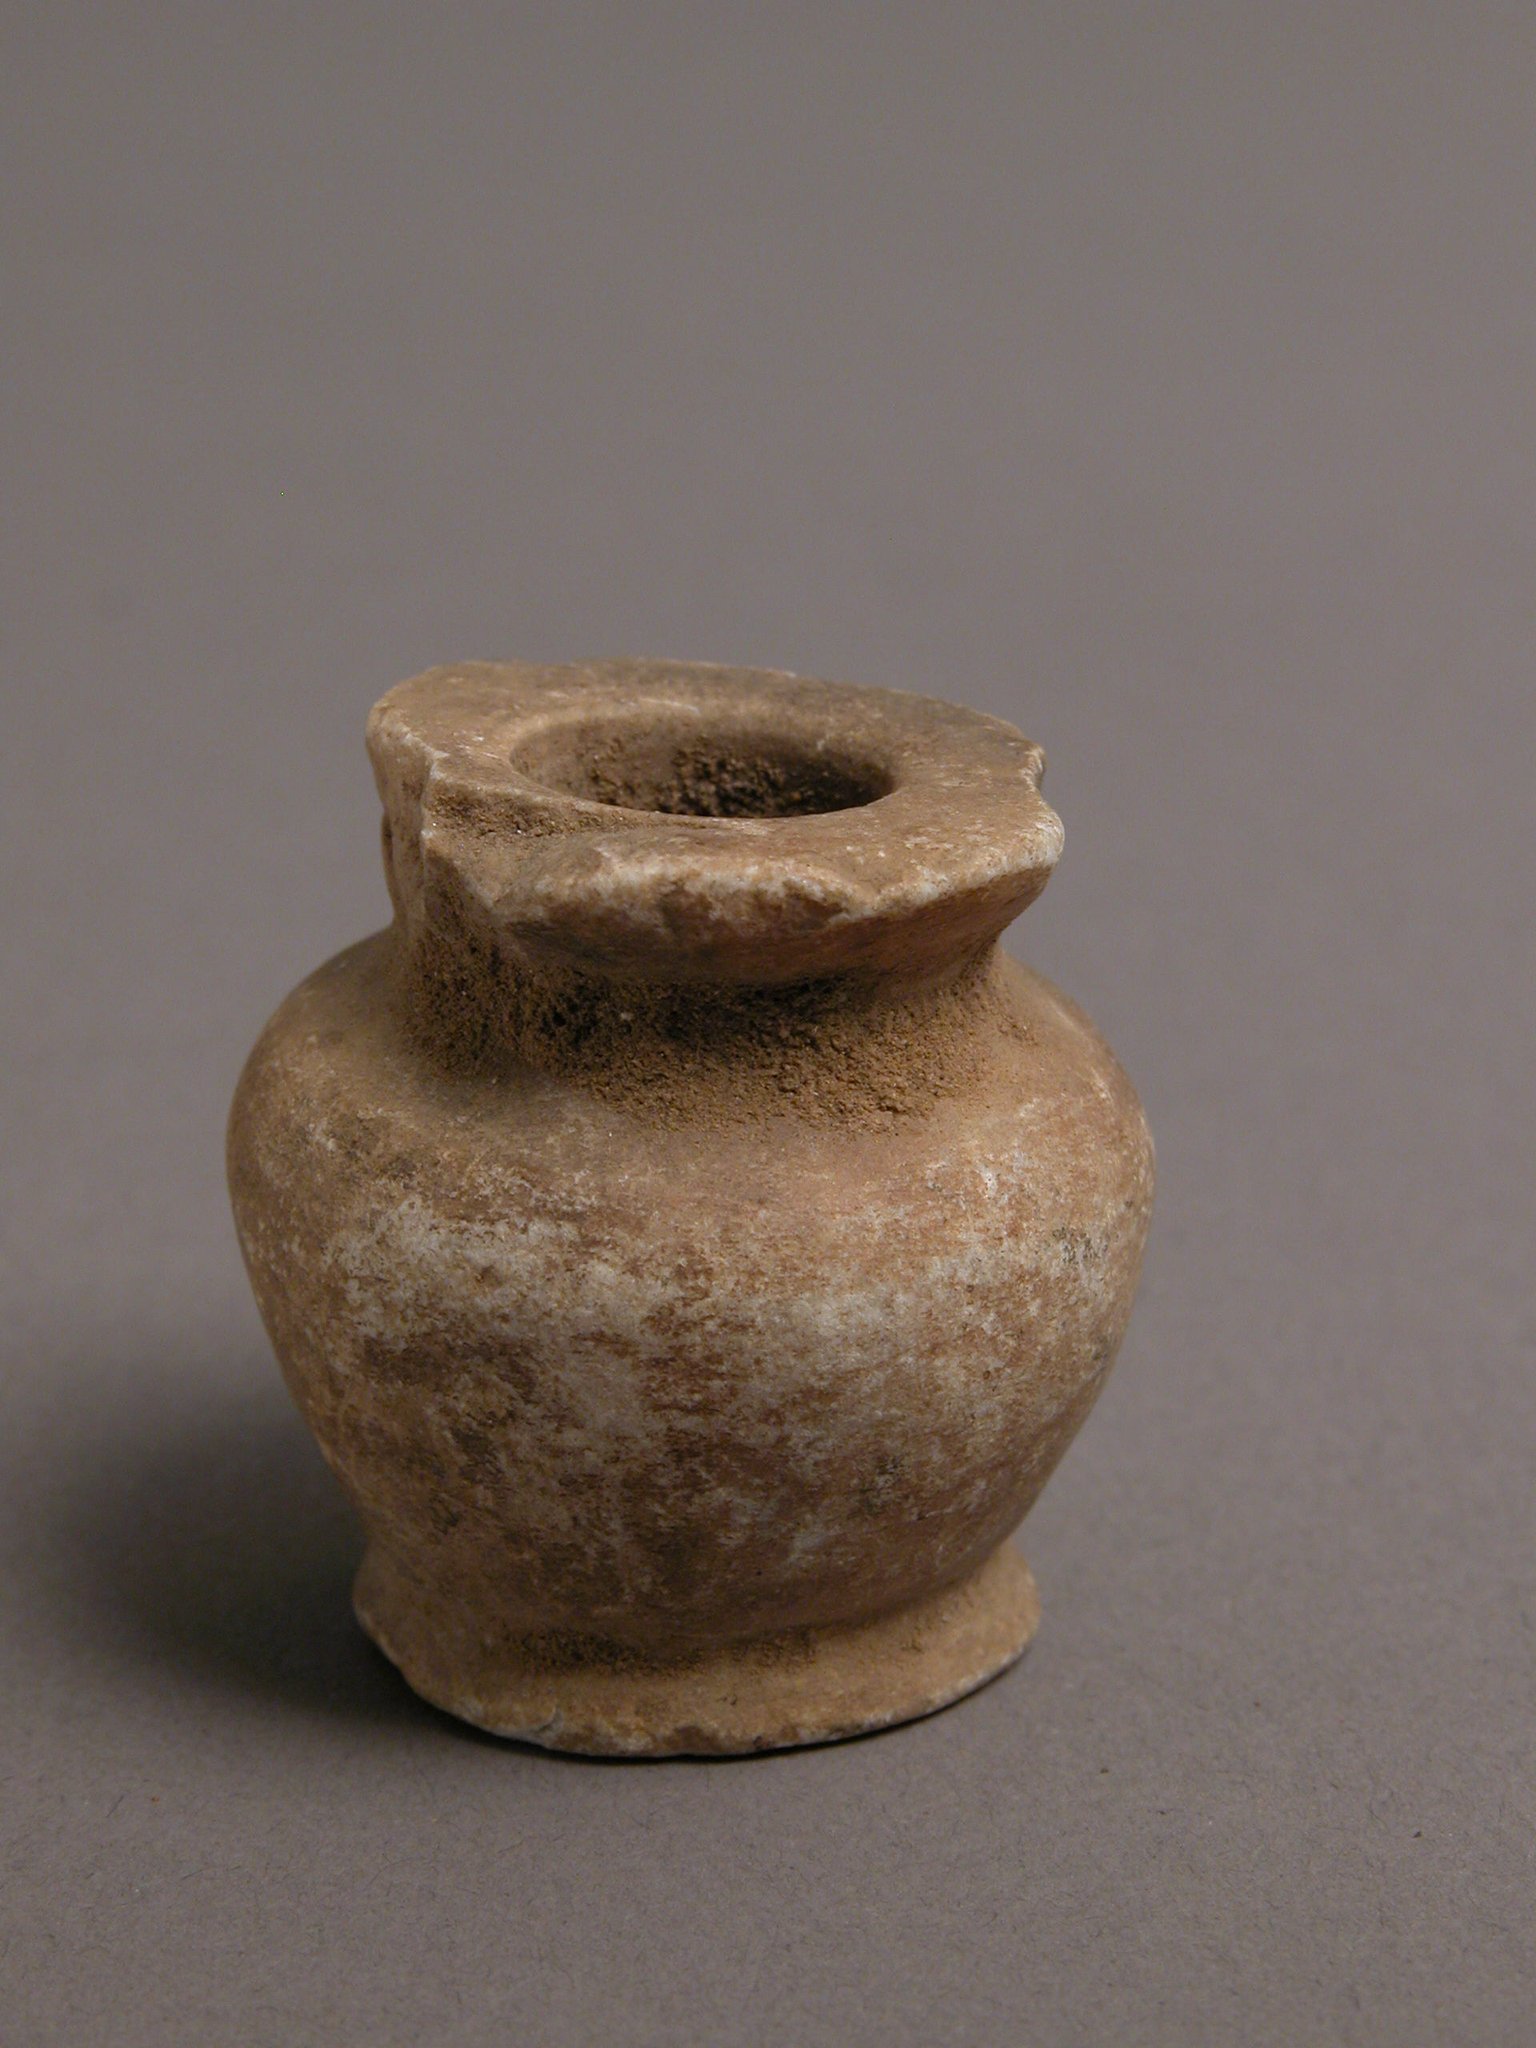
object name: vessel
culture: coptic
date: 301-700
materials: stone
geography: egypt